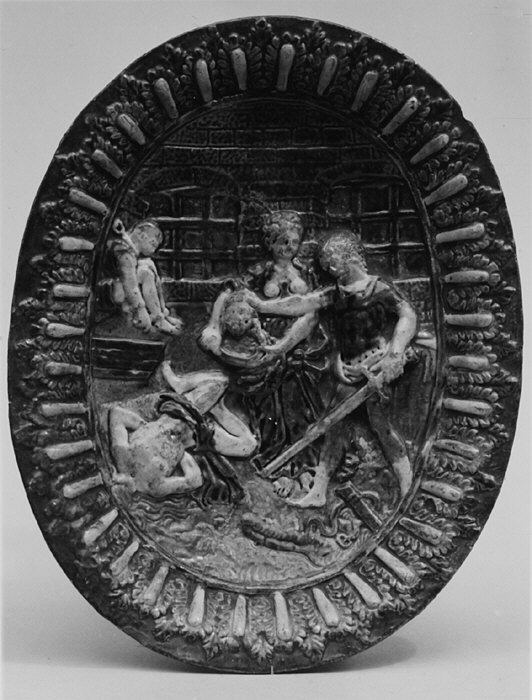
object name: dish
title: Dish with beheading of St. John the Baptist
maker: bernard palissy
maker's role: maker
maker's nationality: french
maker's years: 1510-1590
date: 1651-1700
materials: earthenware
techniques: glazing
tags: swords,women,saint john the baptist